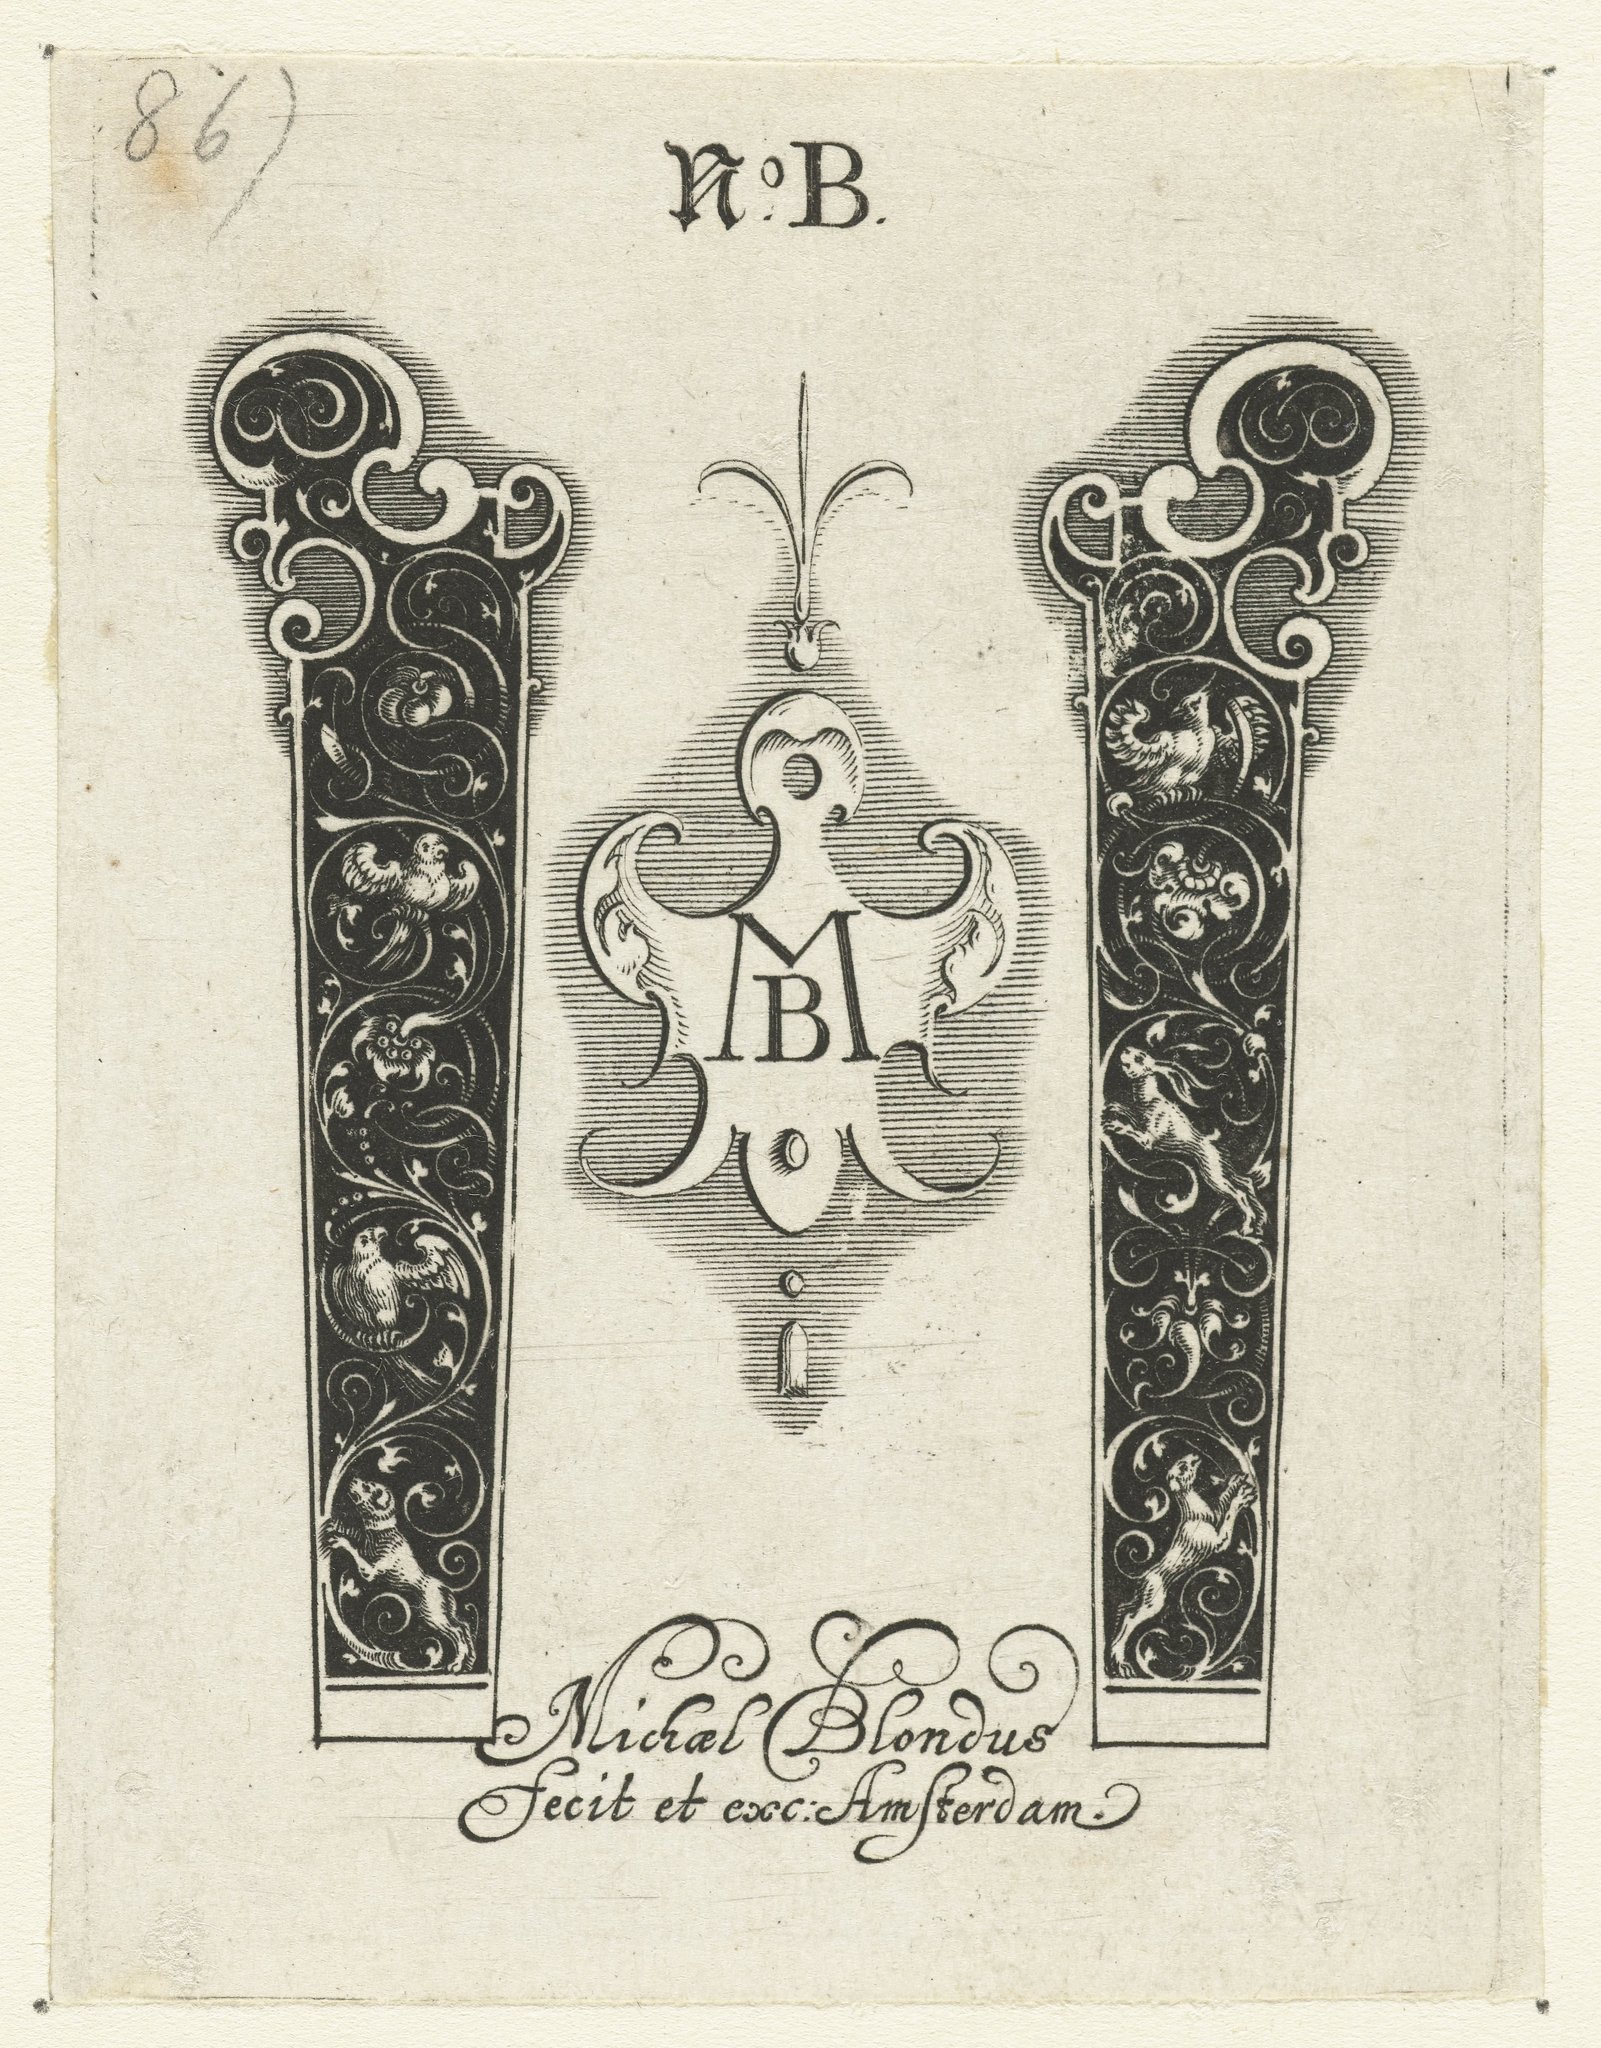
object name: titelblad, titelpagina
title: Twee messenheften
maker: michiel le blon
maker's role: print maker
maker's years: 1587-1656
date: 1597-1626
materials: paper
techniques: etching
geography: amsterdam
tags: table-knife, ornament ~ cartouche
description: Tussen de messenheften hangt een cartouche met het monogram MB. Midden boven staat: N°.B. Uit serie van 6 bladen.